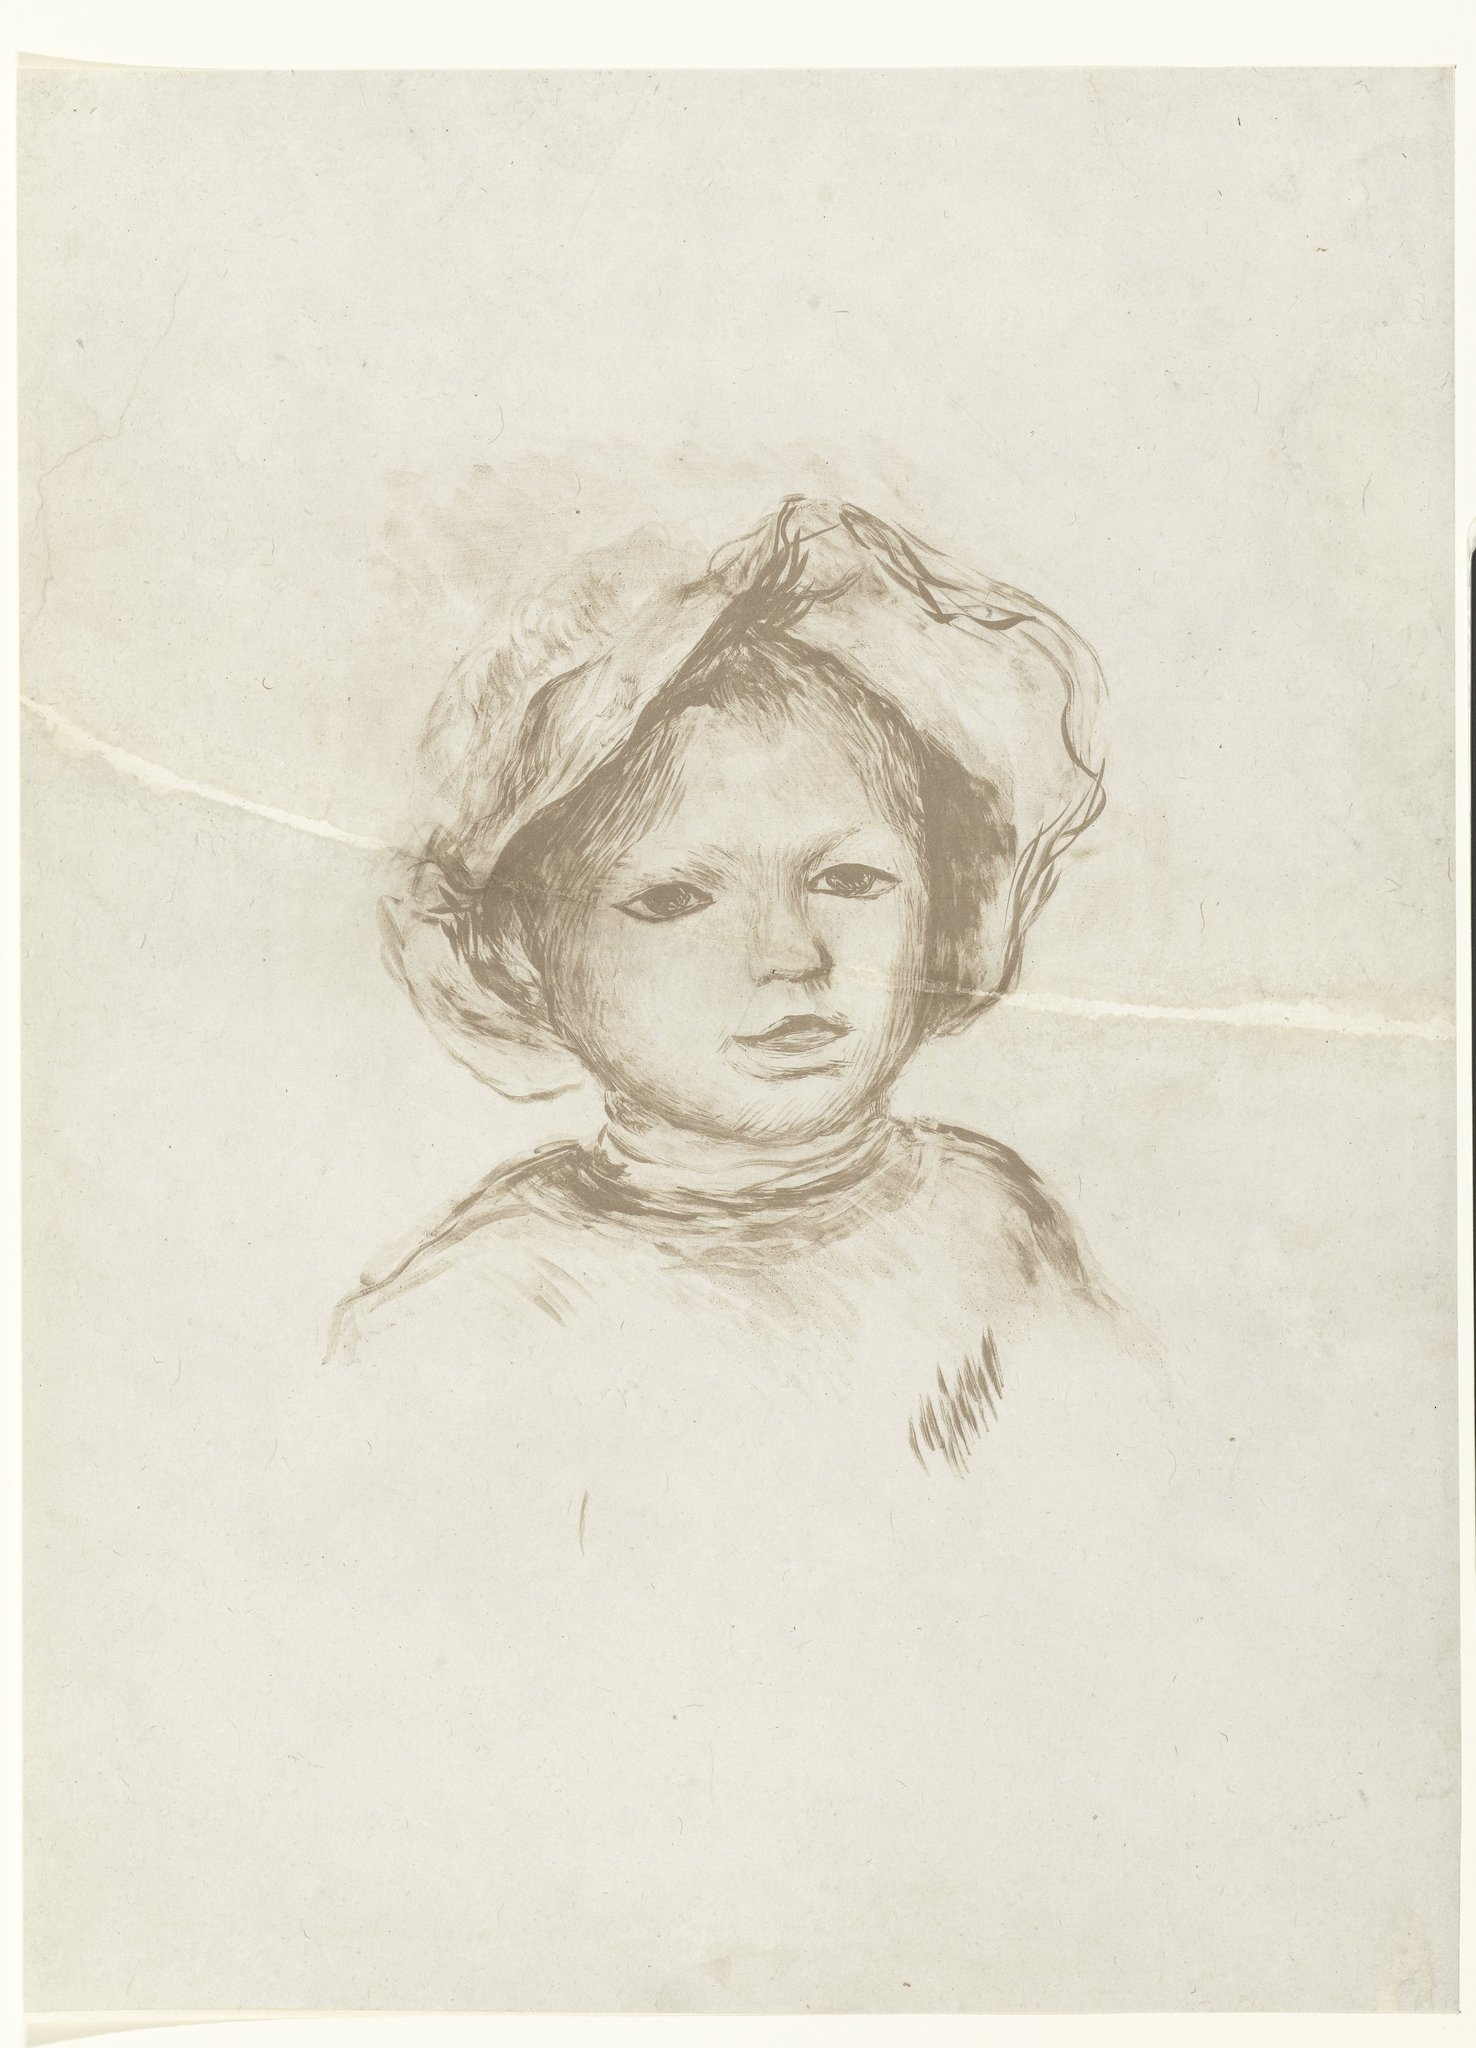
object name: print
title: Portret van Pierre Renoir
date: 1891-1893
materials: paper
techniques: printing, lithograph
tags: boy (child between toddler and youth)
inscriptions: collector's mark: Lugt 2228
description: Portret van de oudste zoon van de kunstenaar, Pierre Renoir, op jonge leeftijd met een hoed op zijn hoofd.